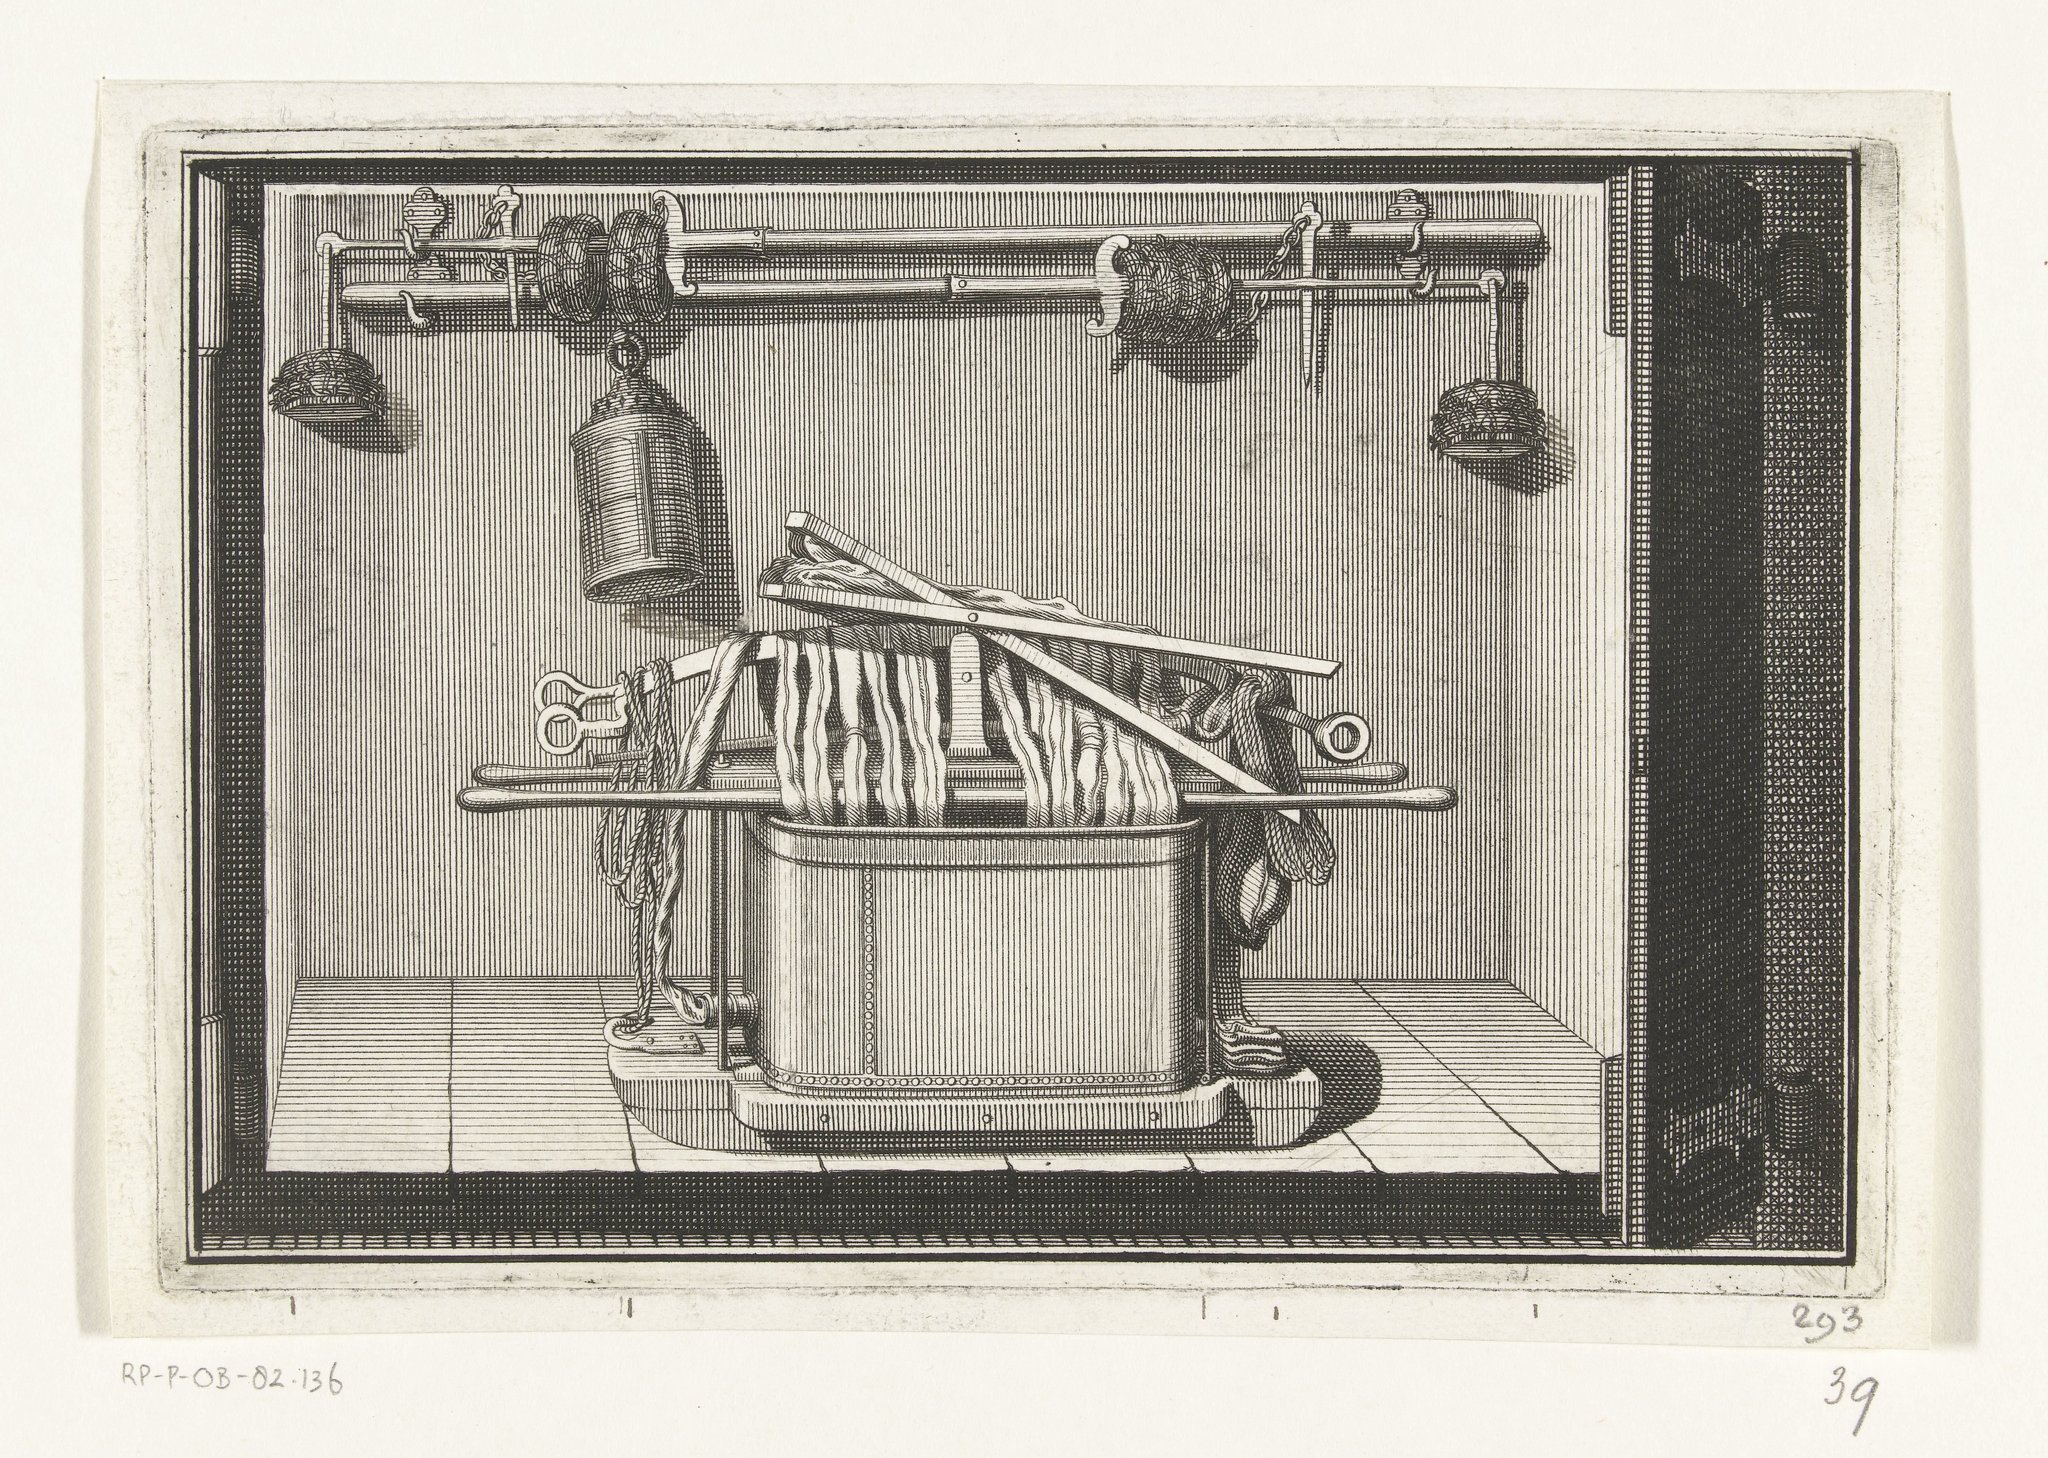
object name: print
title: Slangbrandspuit en pomp opgeborgen in een brandspuithuis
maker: Anonymous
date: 1700-1799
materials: paper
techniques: engraving, etching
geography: northern netherlands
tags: amsterdam, painter, print maker, draughtsman, jan van der heyden, fire-extinguishing equipment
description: Een voorstelling hoe de slangbrandspuit en pomp in het brandspuithuisje opgeborgen dient te worden na gebruik, ca. 1750? Behoort tot de bijprenten bij het Brandspuitenboek van Jan van der Heyden.